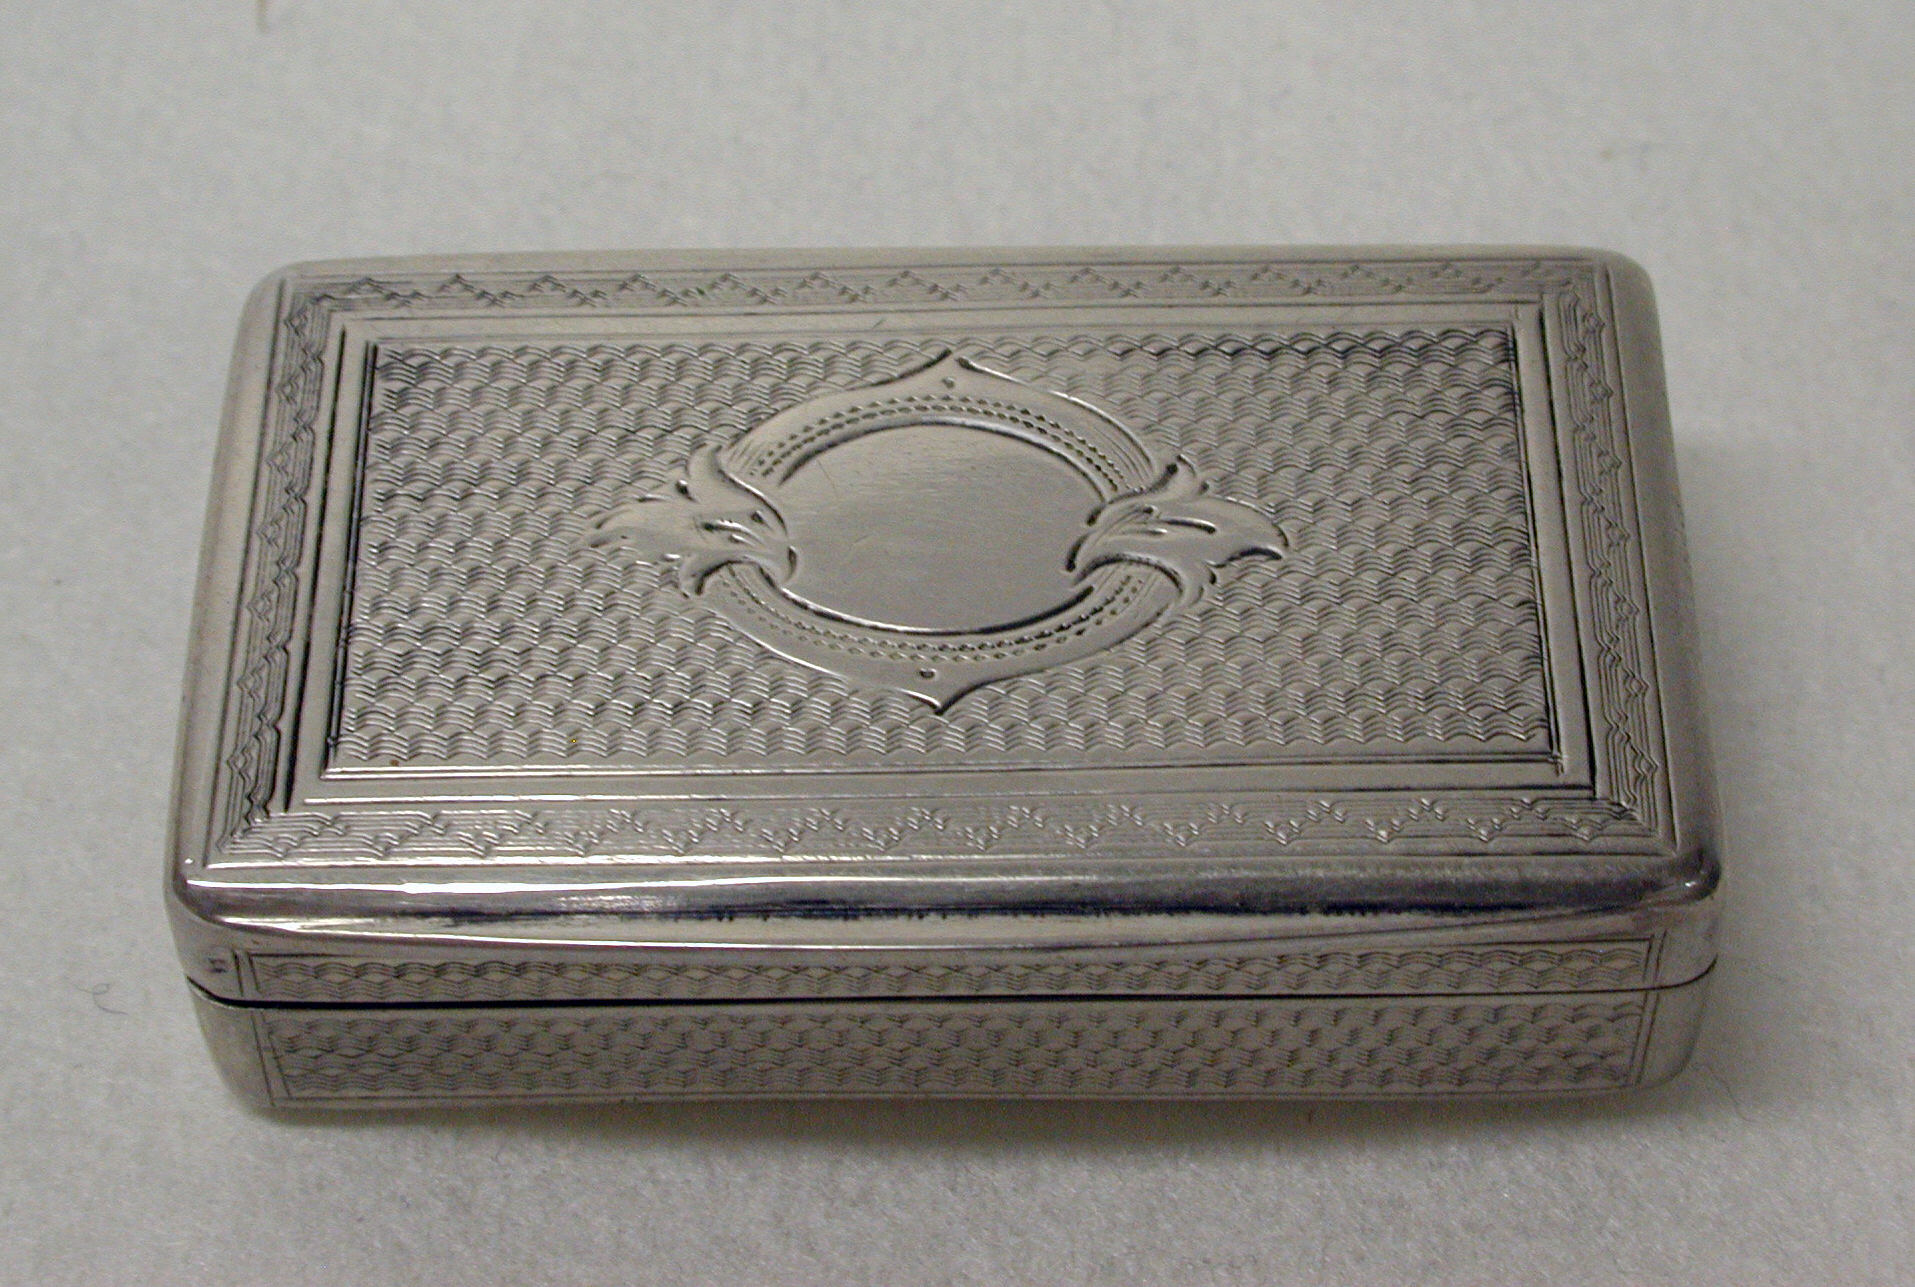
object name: snuffbox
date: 1834-1866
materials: silver